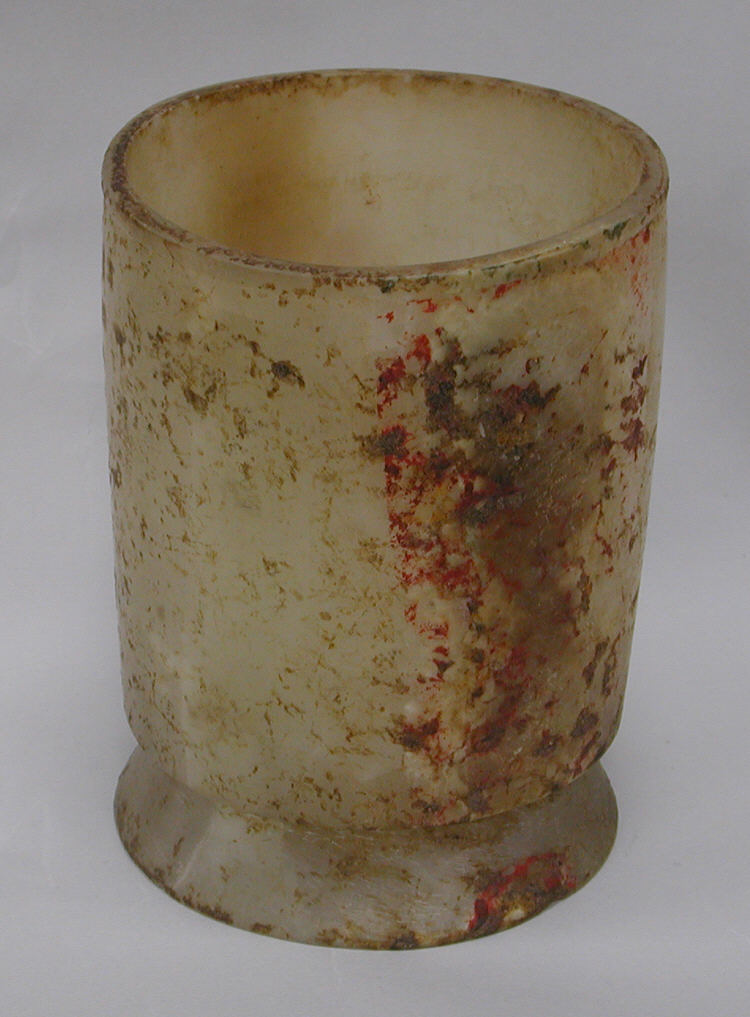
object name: vessel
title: Onyx Cylinder Vessel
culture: mexican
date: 1501-1600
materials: marble, onyx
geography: mexico